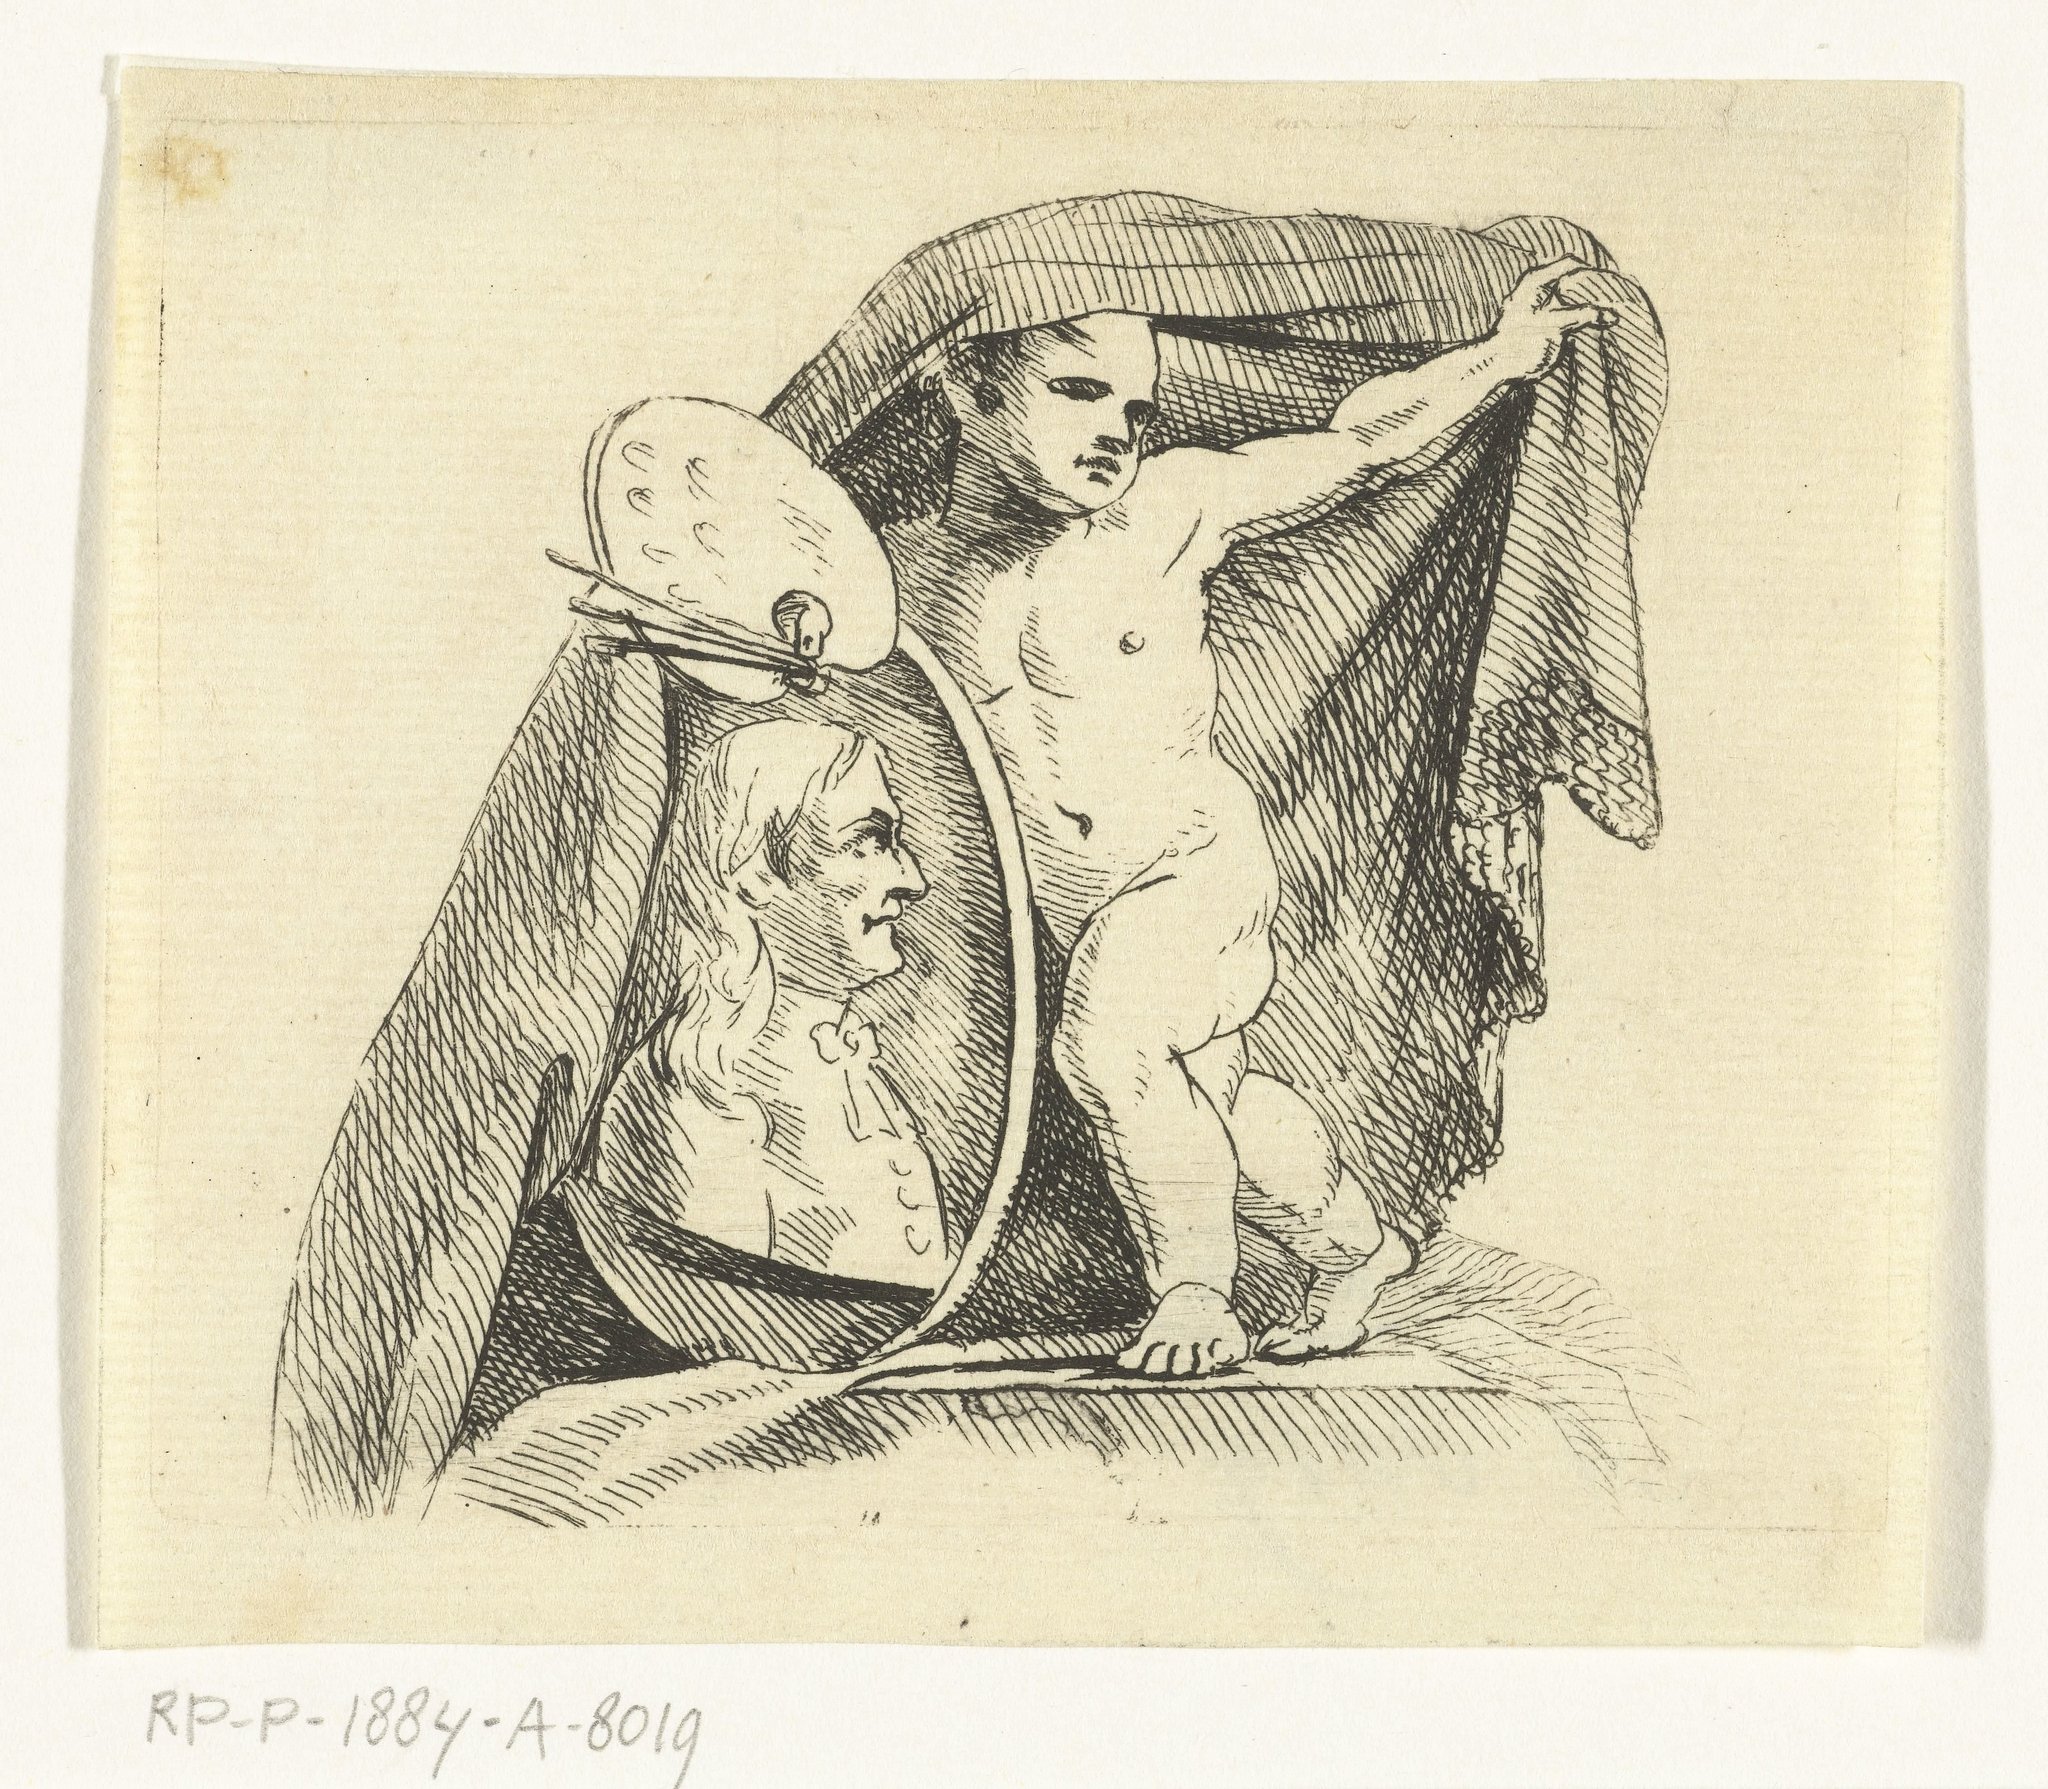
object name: print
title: Naakt kind met schilderspalet en portret van overleden kunstenaar en rouwsluier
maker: antonis aloisius emanuel van bedaff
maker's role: print maker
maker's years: 1787-1829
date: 1797-1829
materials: paper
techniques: etching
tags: mourning dress, 'in memoriam'-card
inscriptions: collector's mark: Lugt 2228